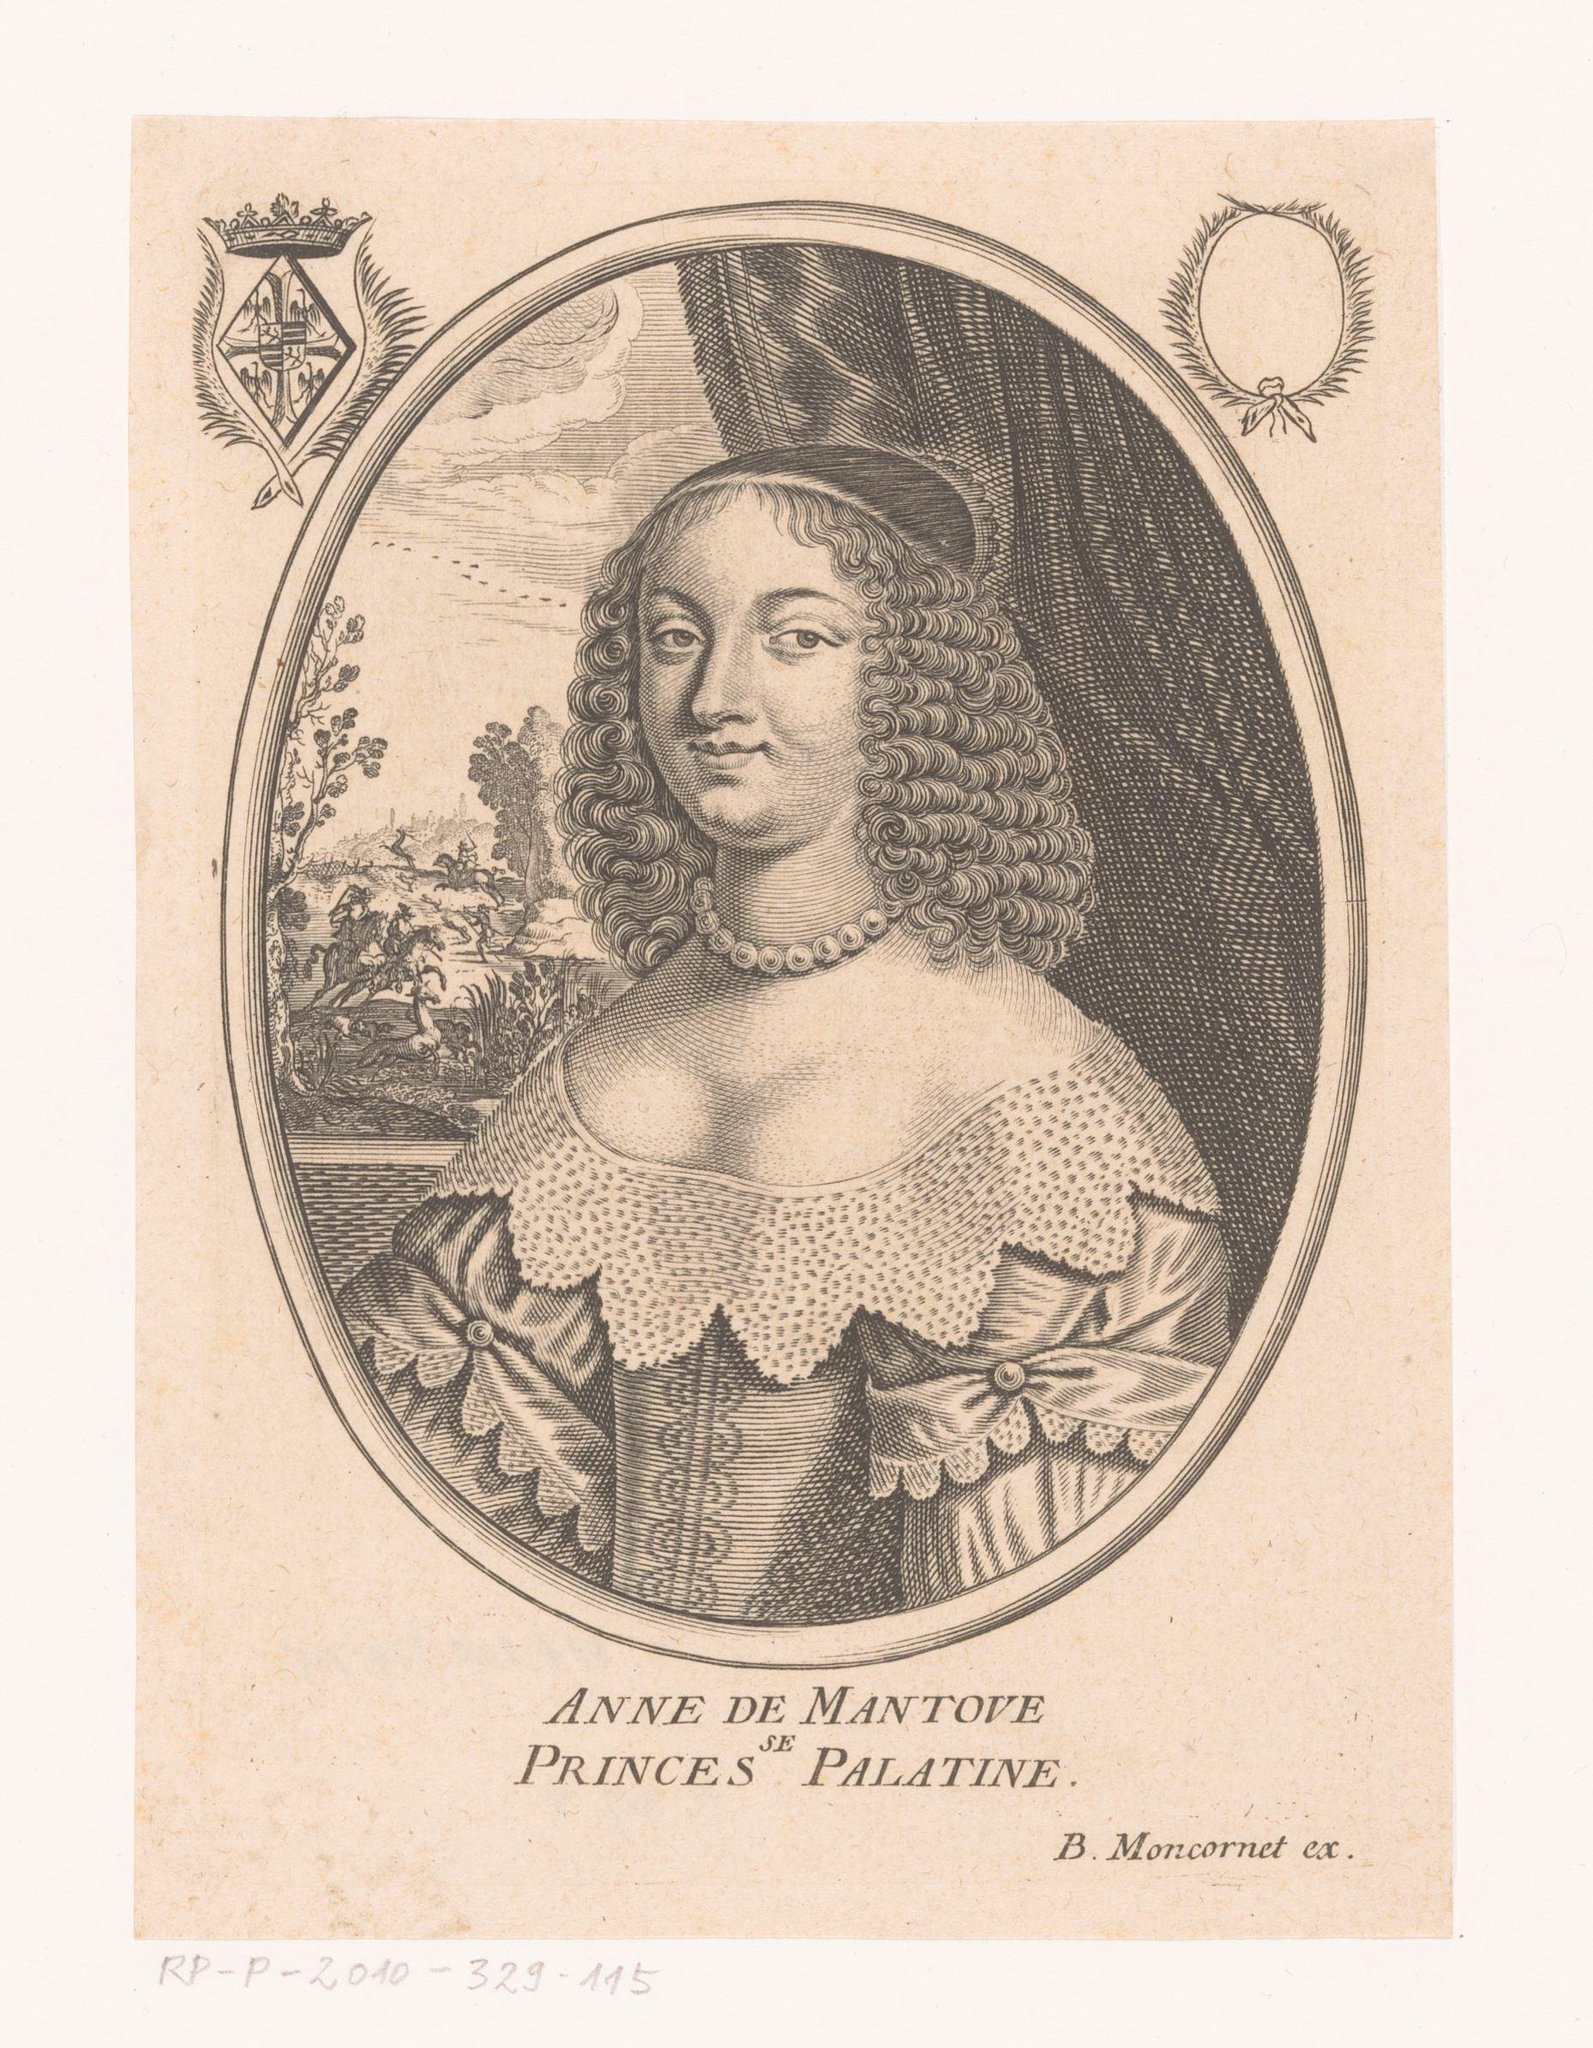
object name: print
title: Portret van Anne Gonzaga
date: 1631-1668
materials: paper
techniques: engraving, etching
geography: paris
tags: historical persons - bb - woman, armorial bearing, heraldry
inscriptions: collector's mark: Lugt 2228